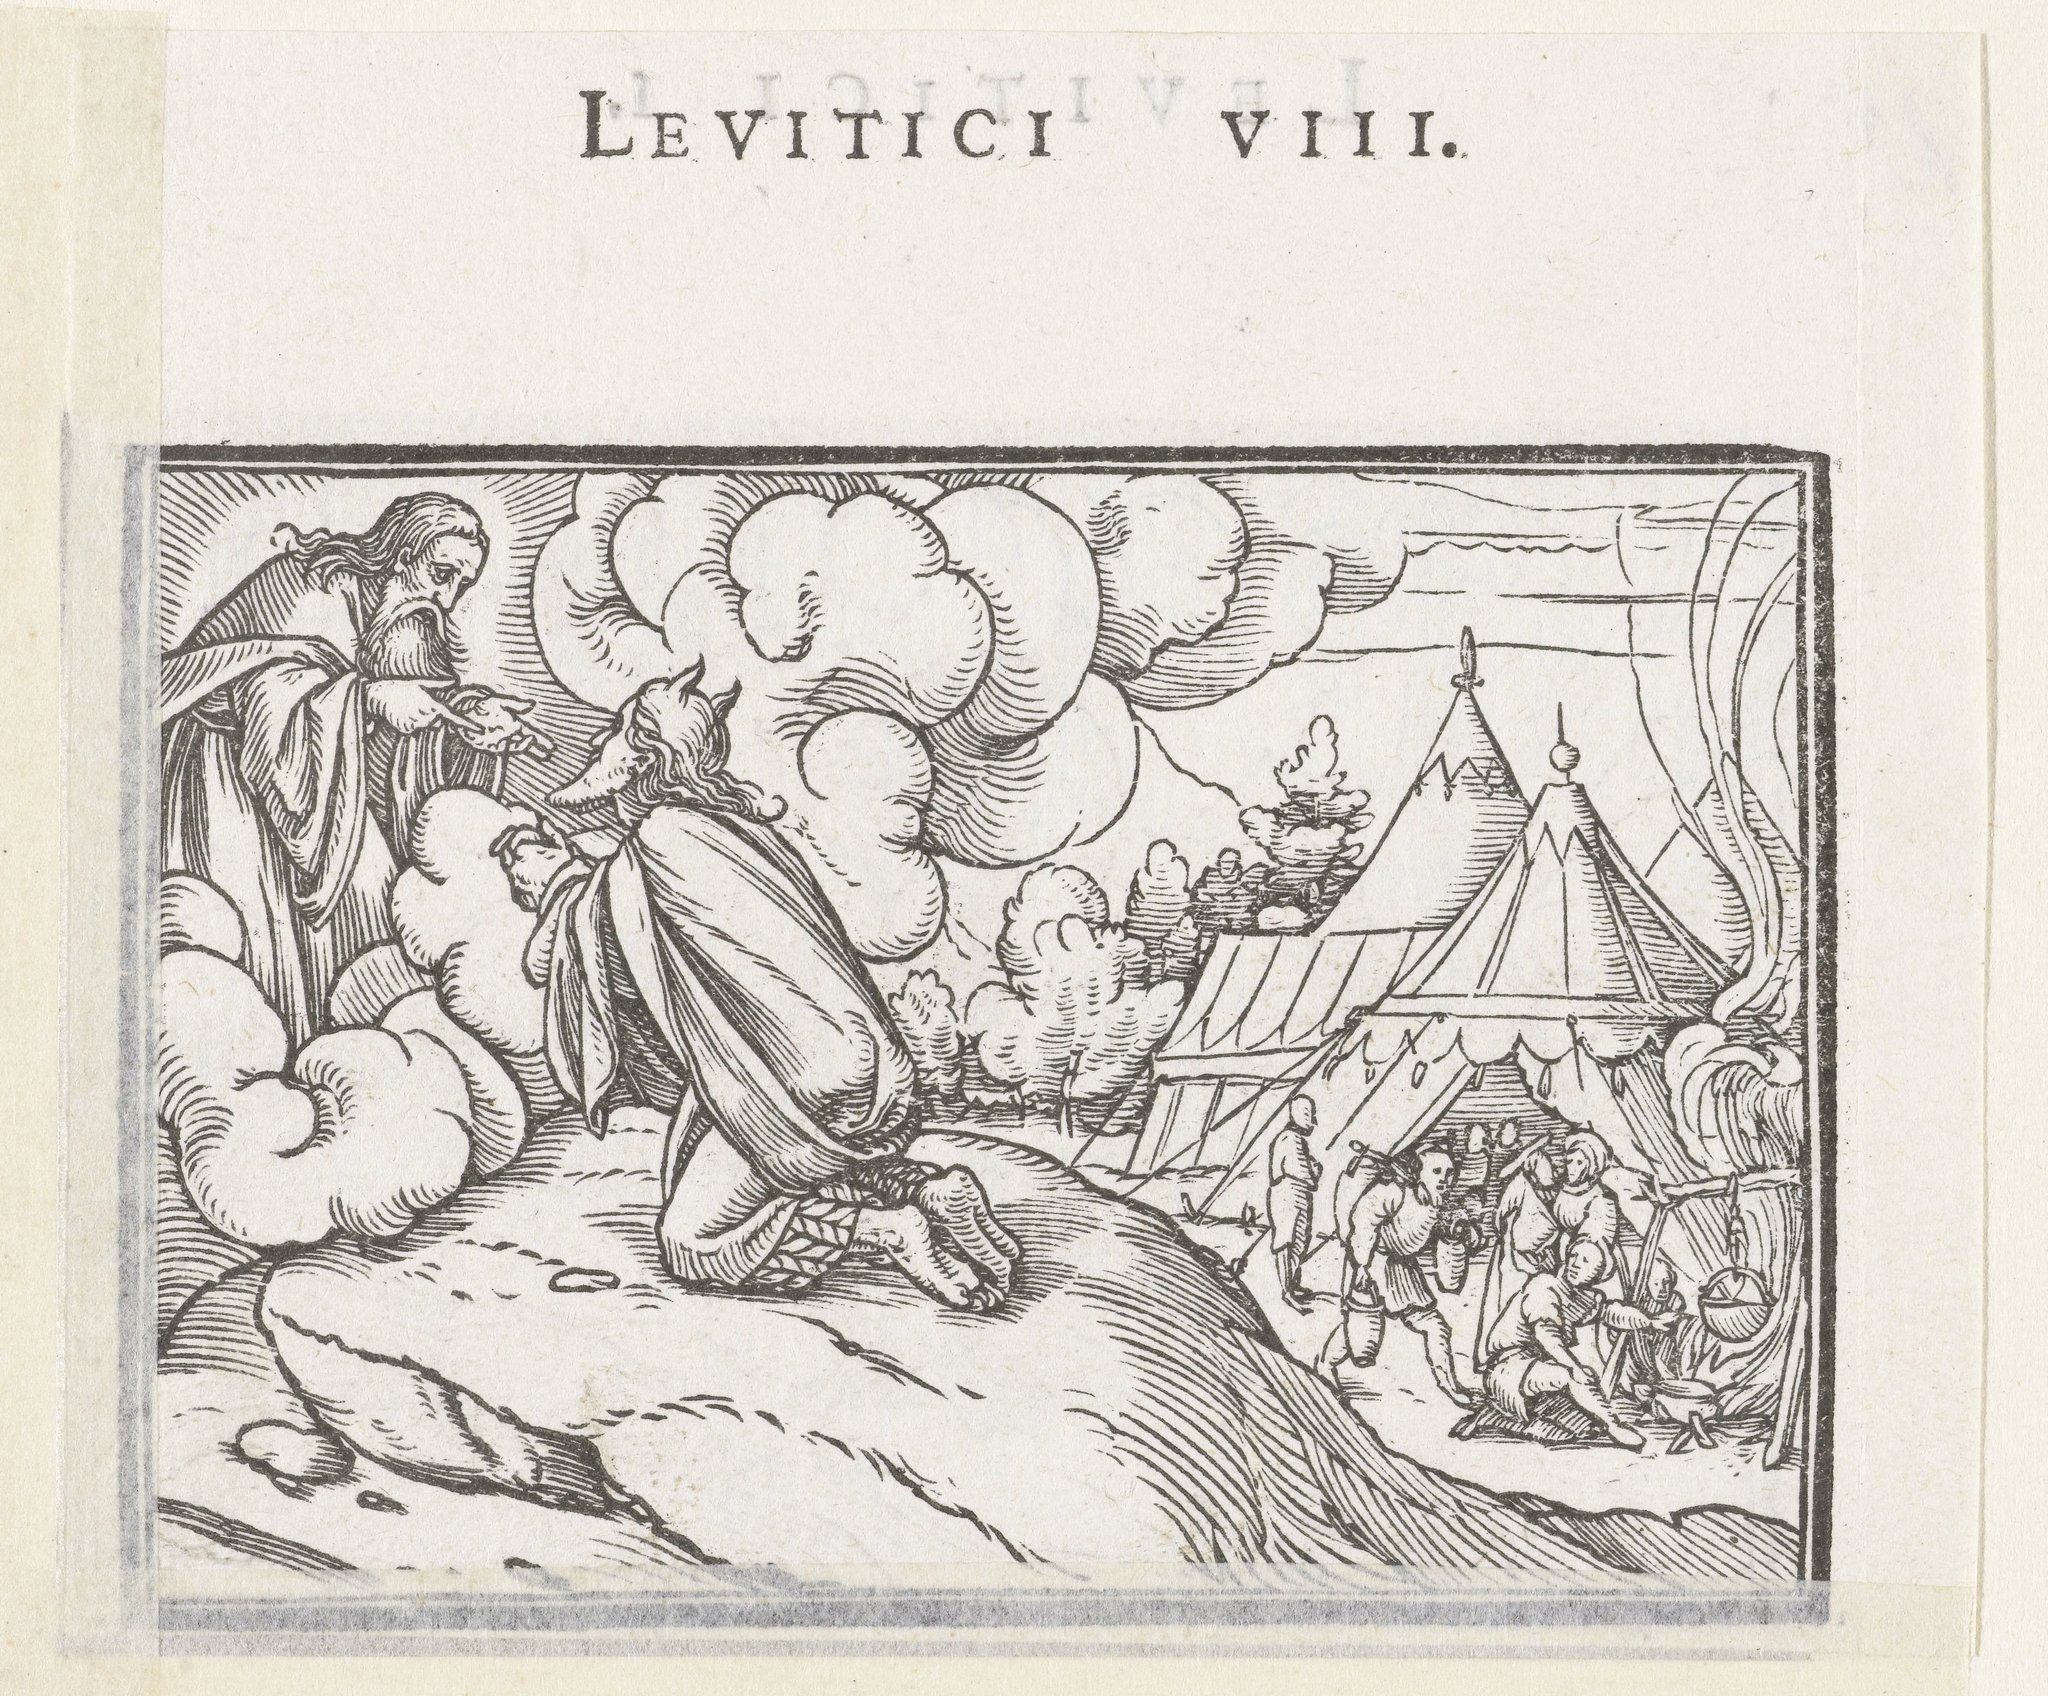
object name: book illustration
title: Mozes ontvangt voorschriften voor de priesterwijding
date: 1538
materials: paper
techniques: woodcut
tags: moses communicating with god on mount sinai (the mountain may be covered by a thick cloud), the book leviticus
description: Houtblok voor het eerst gebruikt in: Biblia Utriusque Testamenti iuxta Vulgatam Translationem, Lyon, M. en G. Trechsel (voor Hugo à Porta) 1538. Later in verschillende uitgaven opnieuw gebruikt.